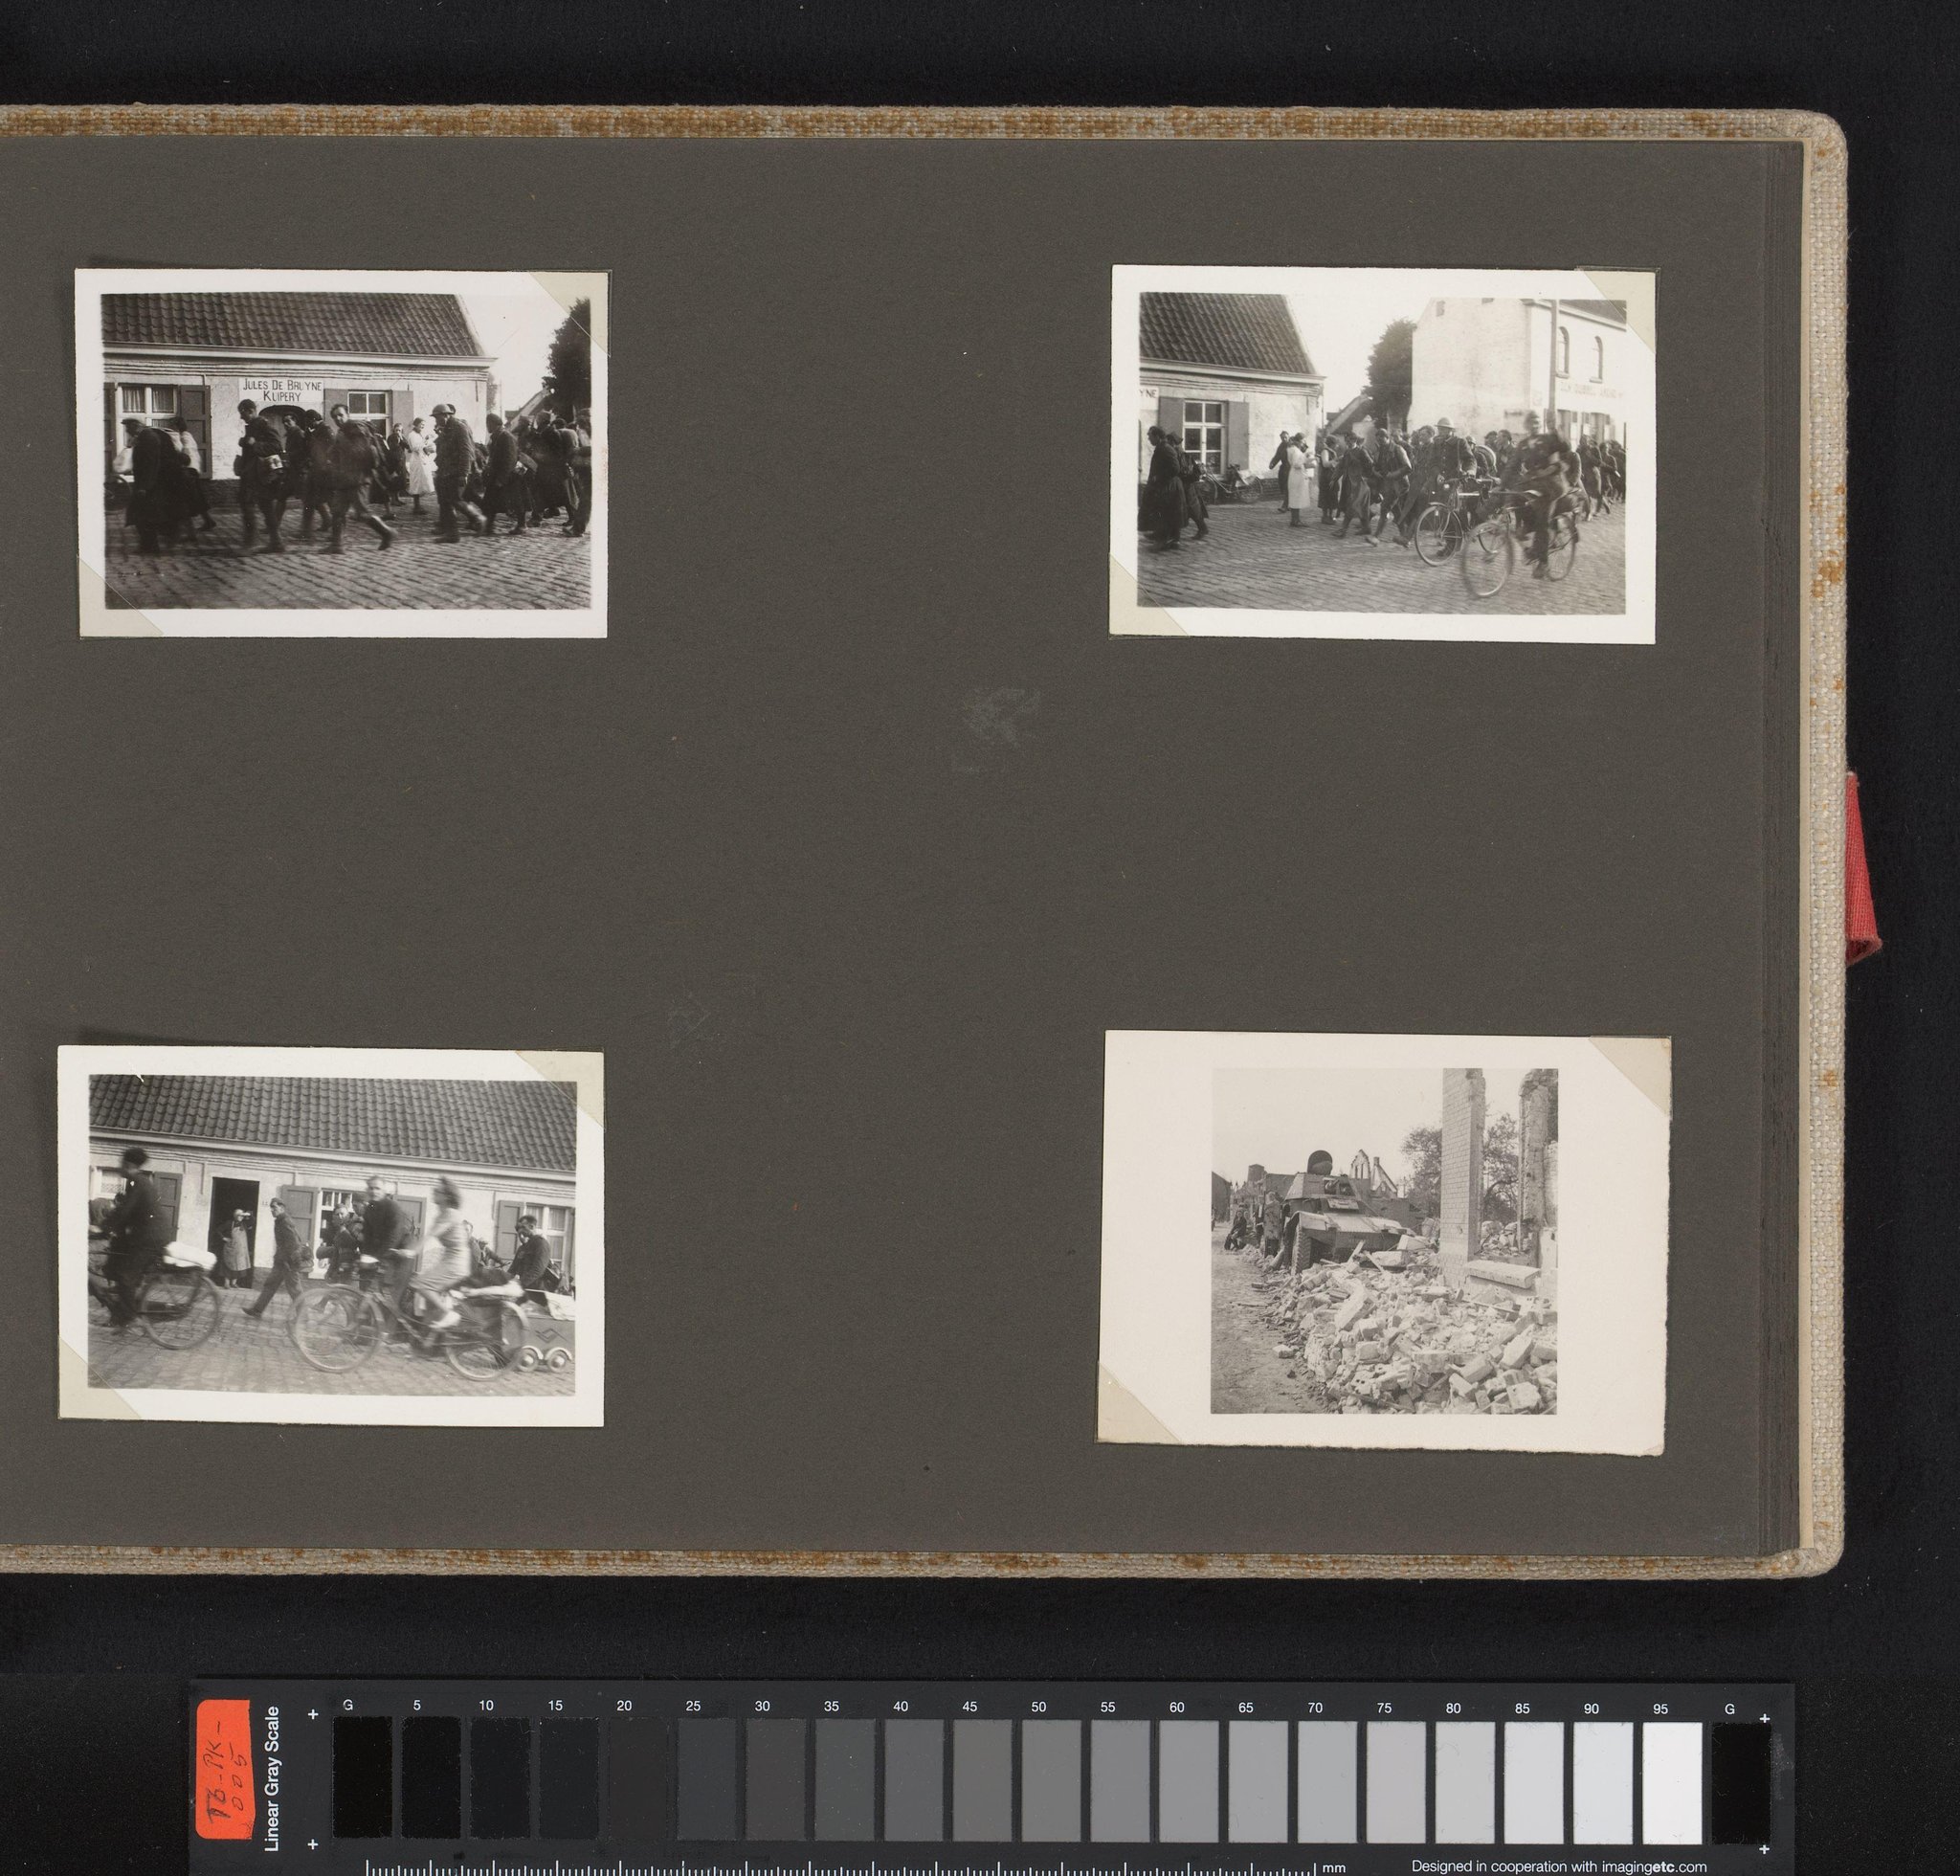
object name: photograph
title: Oorlogsschade en krijgsgevangenen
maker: Anonymous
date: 1906-1940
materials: cardboard, photographic support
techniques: gelatin silver print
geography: belgium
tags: devastated, ruined place or city (~ warfare), prisoner of war (after the battle), belgium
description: Albumblad met vier foto's van een stoet Franse of Engelse koloniale krijgsgevangenen in België en oorlogsschade, juni 1940. Onderdeel van de fotoalbum van de Wehrmacht 1938-1941.